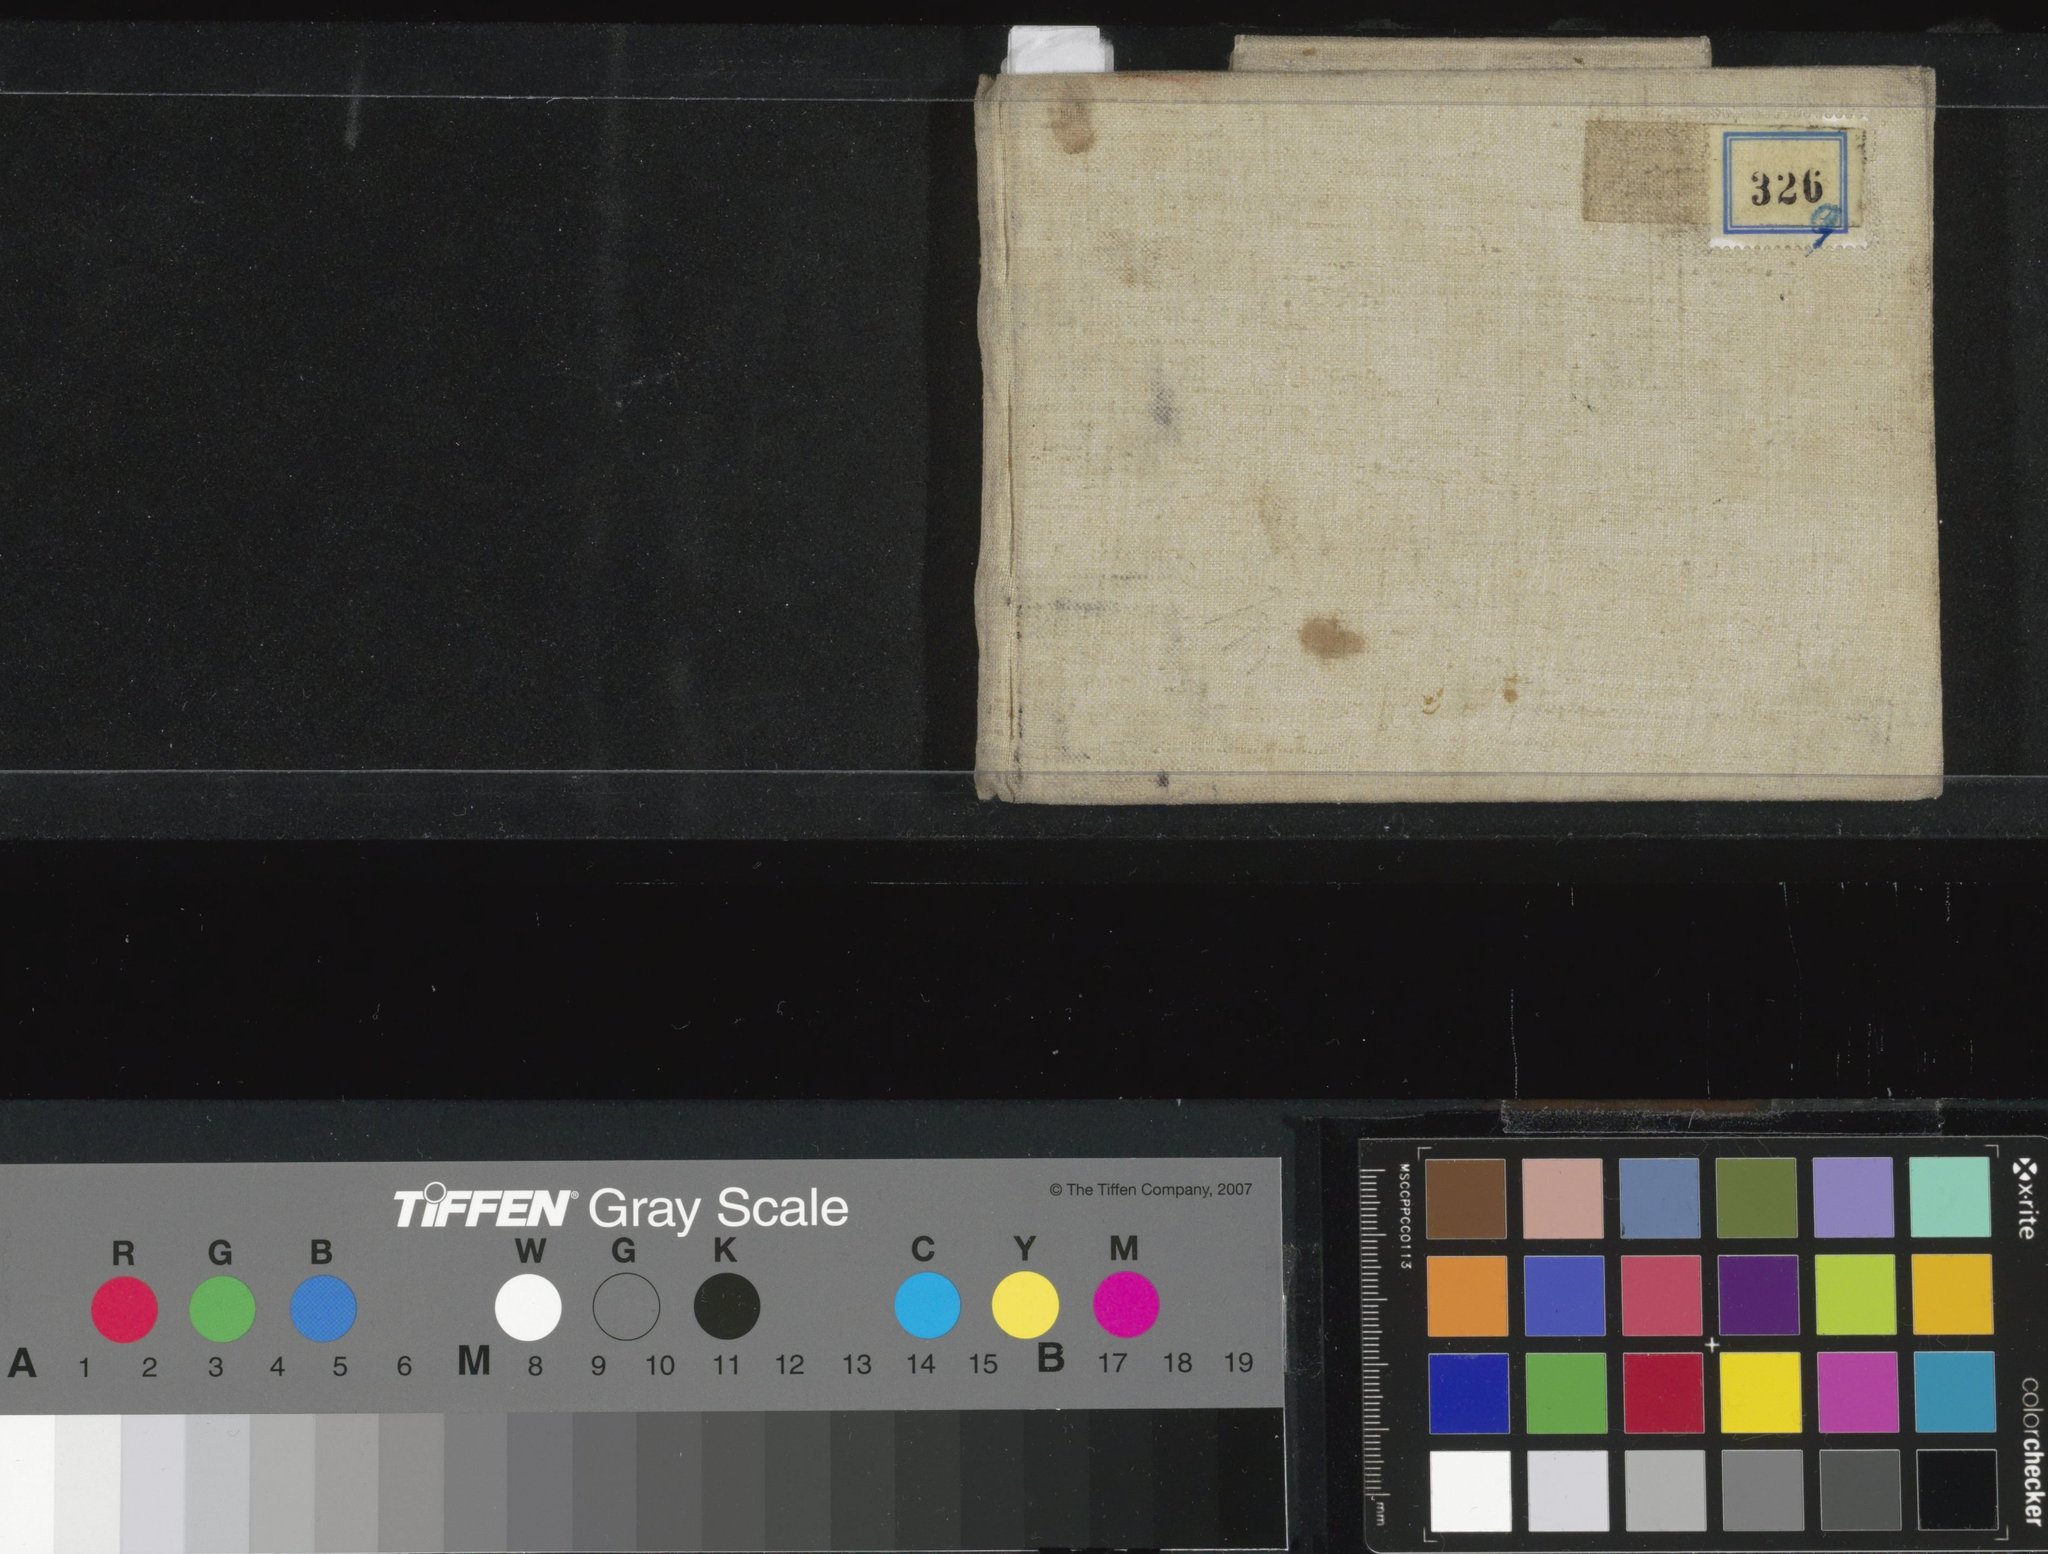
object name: sketchbook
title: Schetsboek met 29 bladen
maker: anton mauve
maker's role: draughtsman, painter, print maker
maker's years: 1838-1888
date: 1881-1888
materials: cardboard, chalk, ink, linen, paper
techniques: brush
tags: cattle, head (human) (+ male human being (not to be used where -a- is prescribed)), landscapes (+ landscape with figures, staffage)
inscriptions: label: ‘326/ 9’, collector's mark: Lugt 2228a, workshop stamp: ‘Atelier/ A Mauve.’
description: Schetsboek bestaande uit 29 bladen met voornamelijk landschappen met molens, water, vee en figuren en enkele portretkoppen.